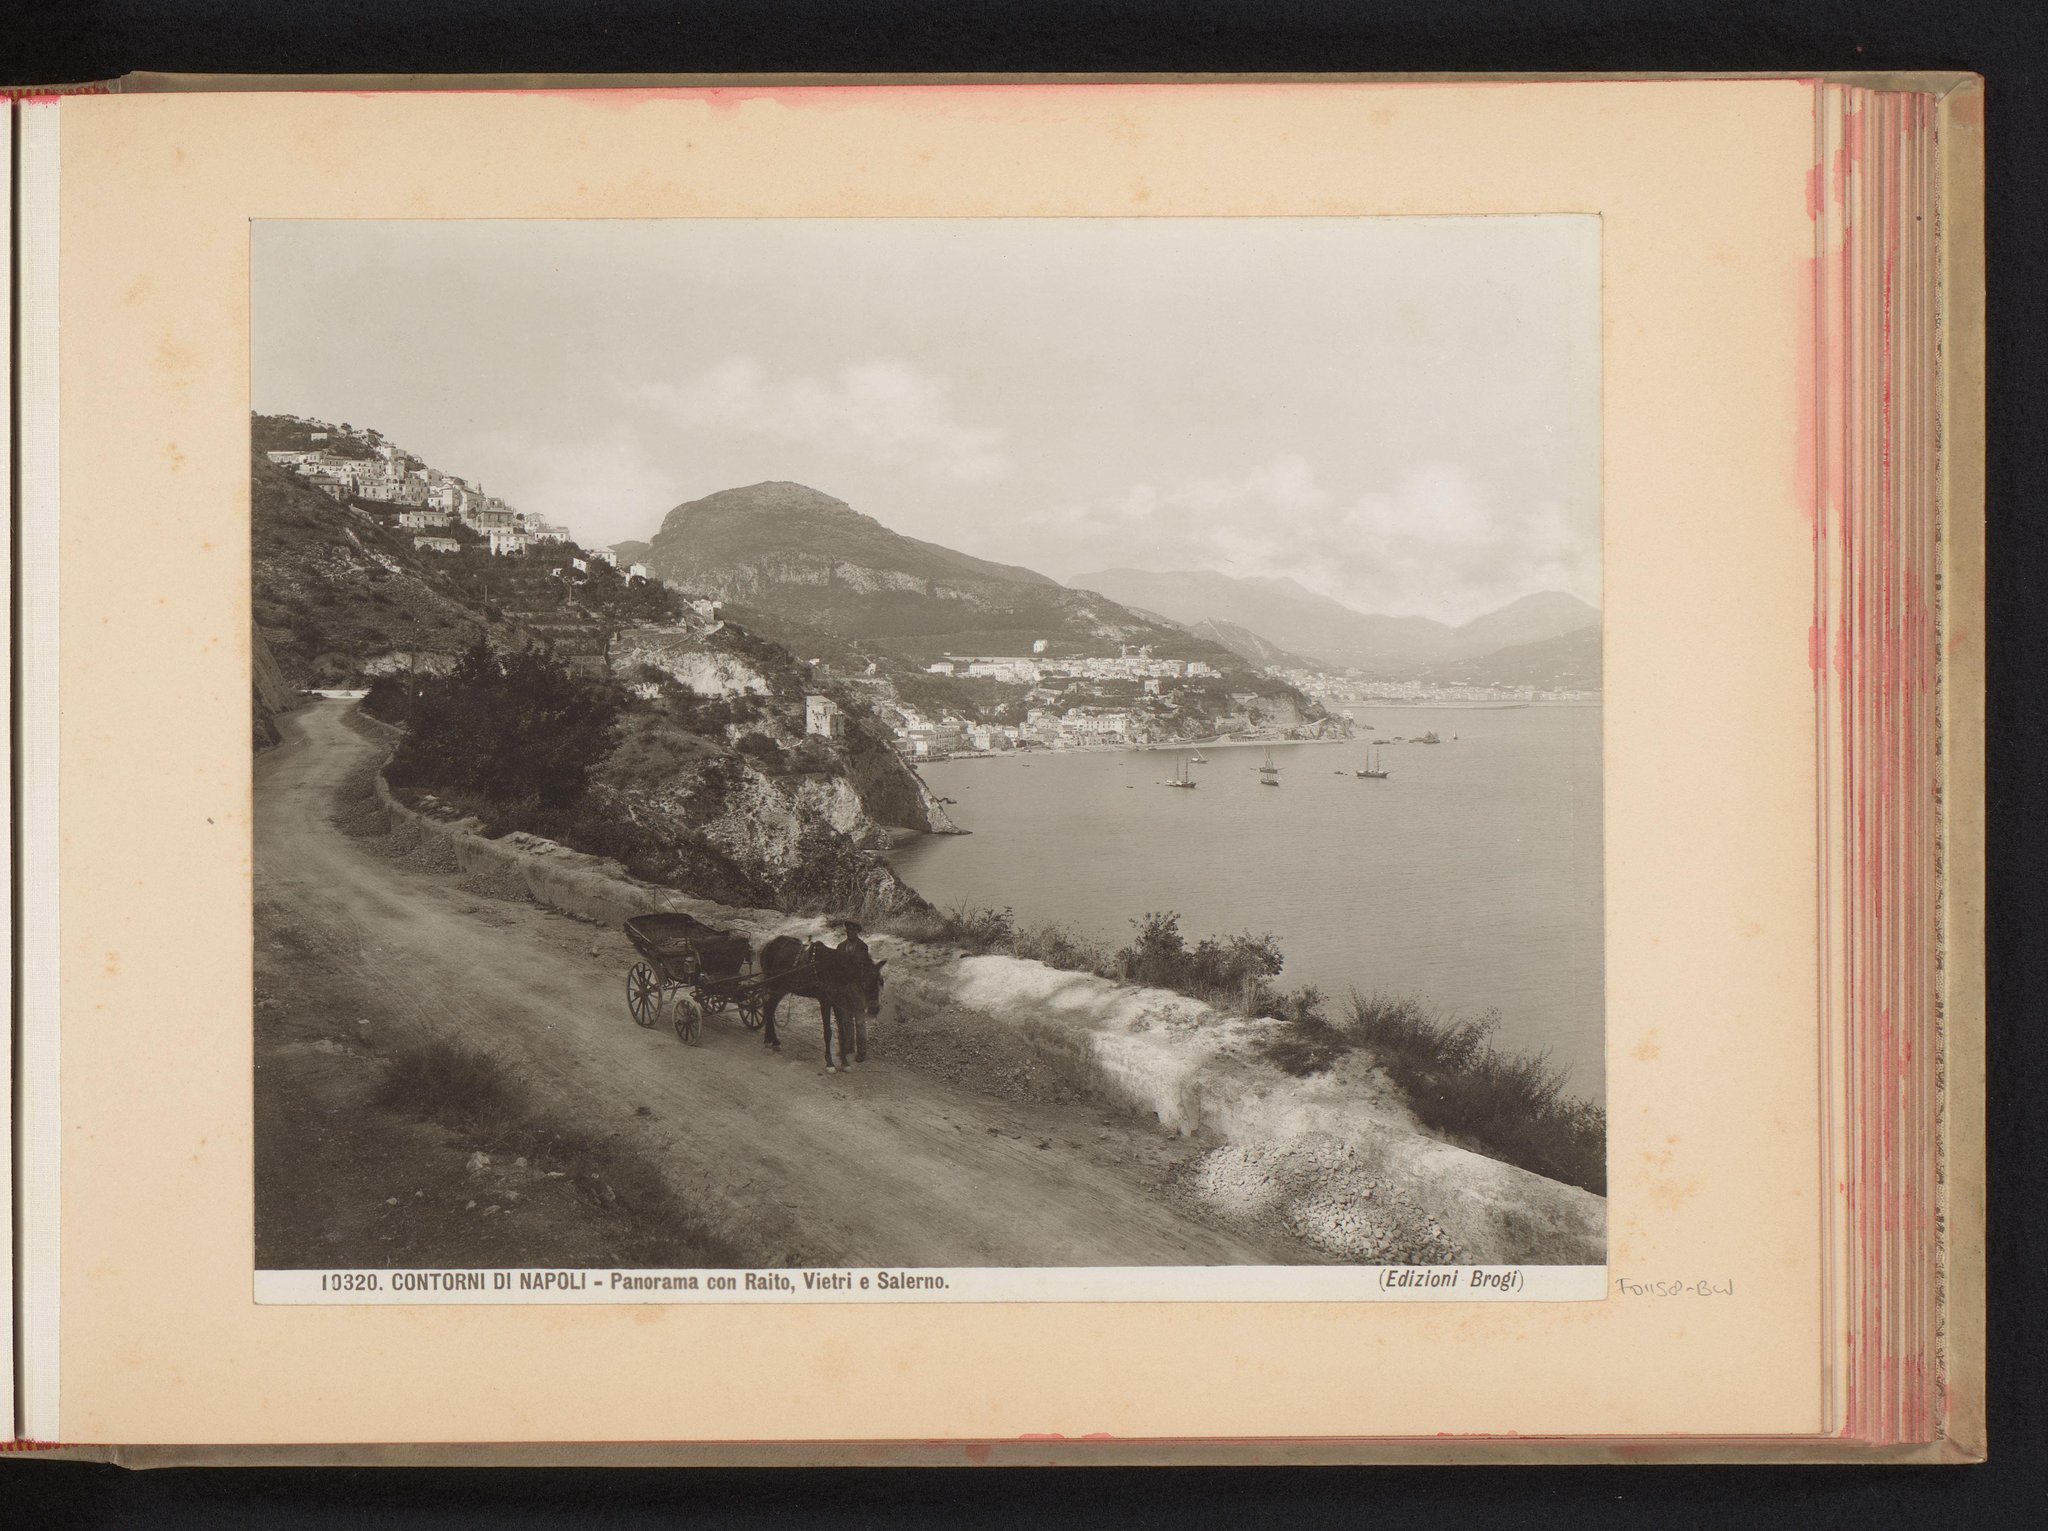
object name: photograph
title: Gezicht op Raito, Vietri sul Mare en Salerno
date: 1875-1907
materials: photographic support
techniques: gelatin silver print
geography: salerno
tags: city-view in general; 'veduta', rocky coast, salerno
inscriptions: number: ‘10320’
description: Onderdeel van Fotoalbum met opnames van bezienswaardigheden en kunstwerken in Italië.